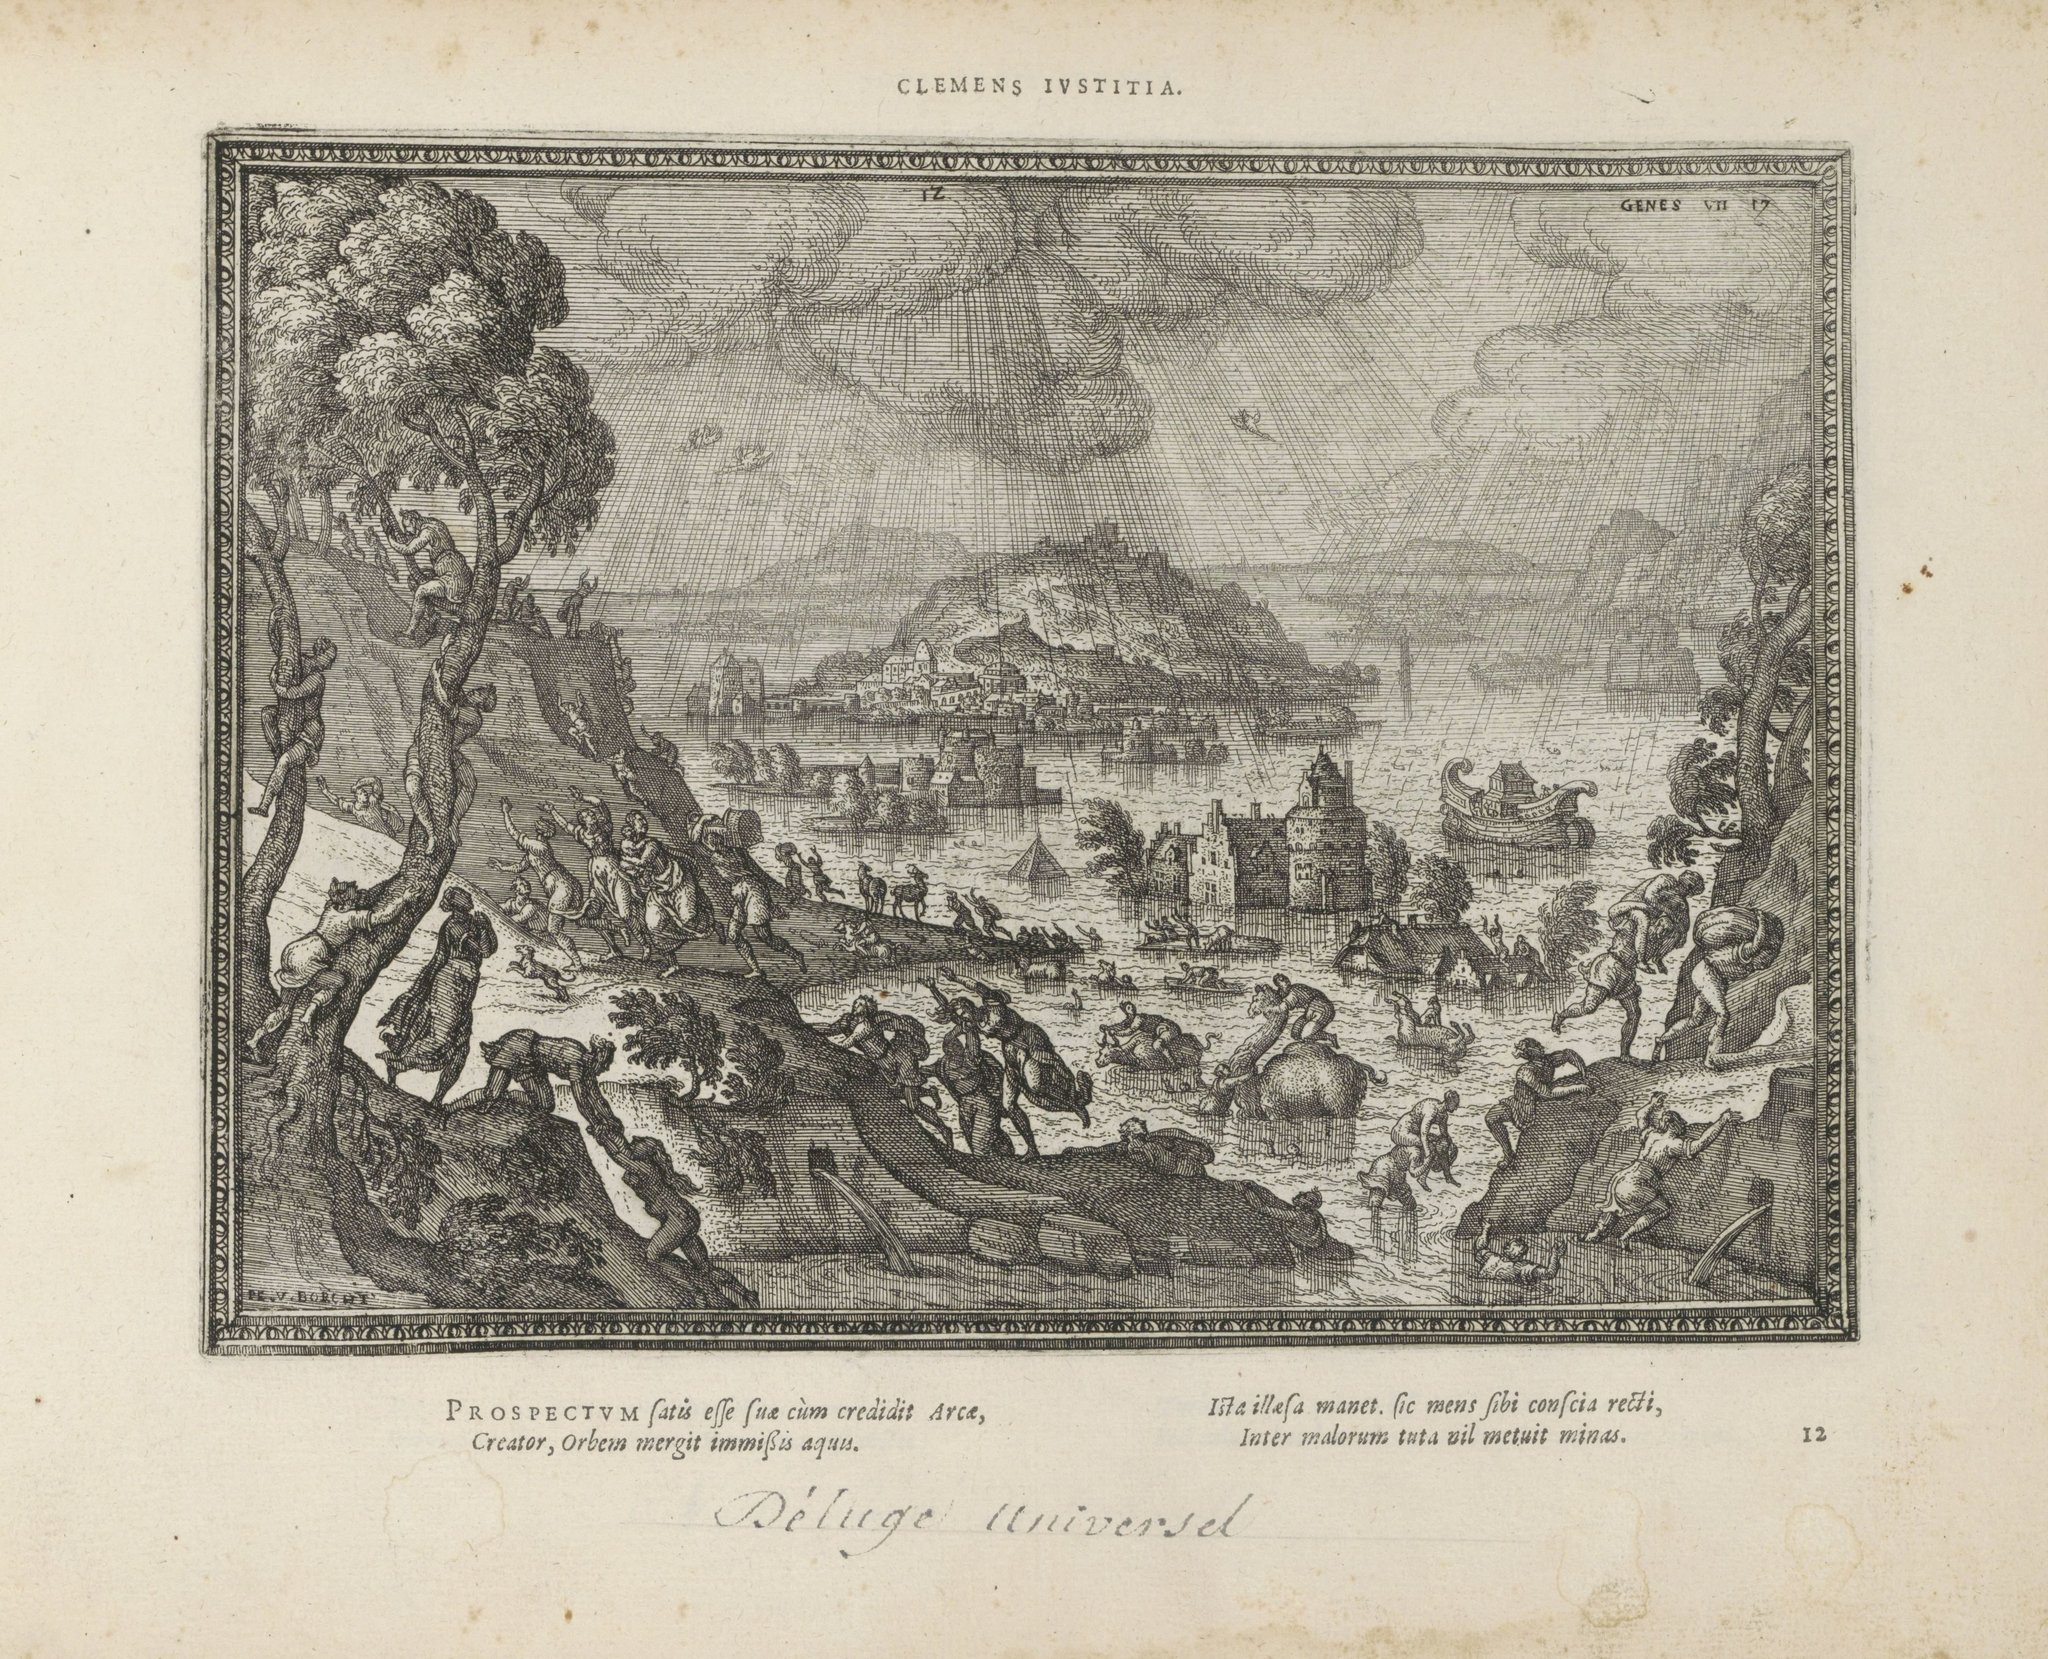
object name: album leaf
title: Zondvloed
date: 1582-1593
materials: paper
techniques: etching, letterpress printing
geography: amsterdam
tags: the ark is floating on the waters, while life on earth is destroyed ~ story of noah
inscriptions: inscription: ‘Déluge Universel’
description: De zondvloed. Het regent en het land staat onder water. Op de voorgrond proberen de mensen zich op hoger gelegen land in veiligheid te brengen. Links zijn mensen in de boom geklommen (Gen. 7:17). Met een motto in het Latijn boven de voorstelling en een vierregelig onderschrift in het Latijn onder de prent. De prent maakt deel uit van een album.